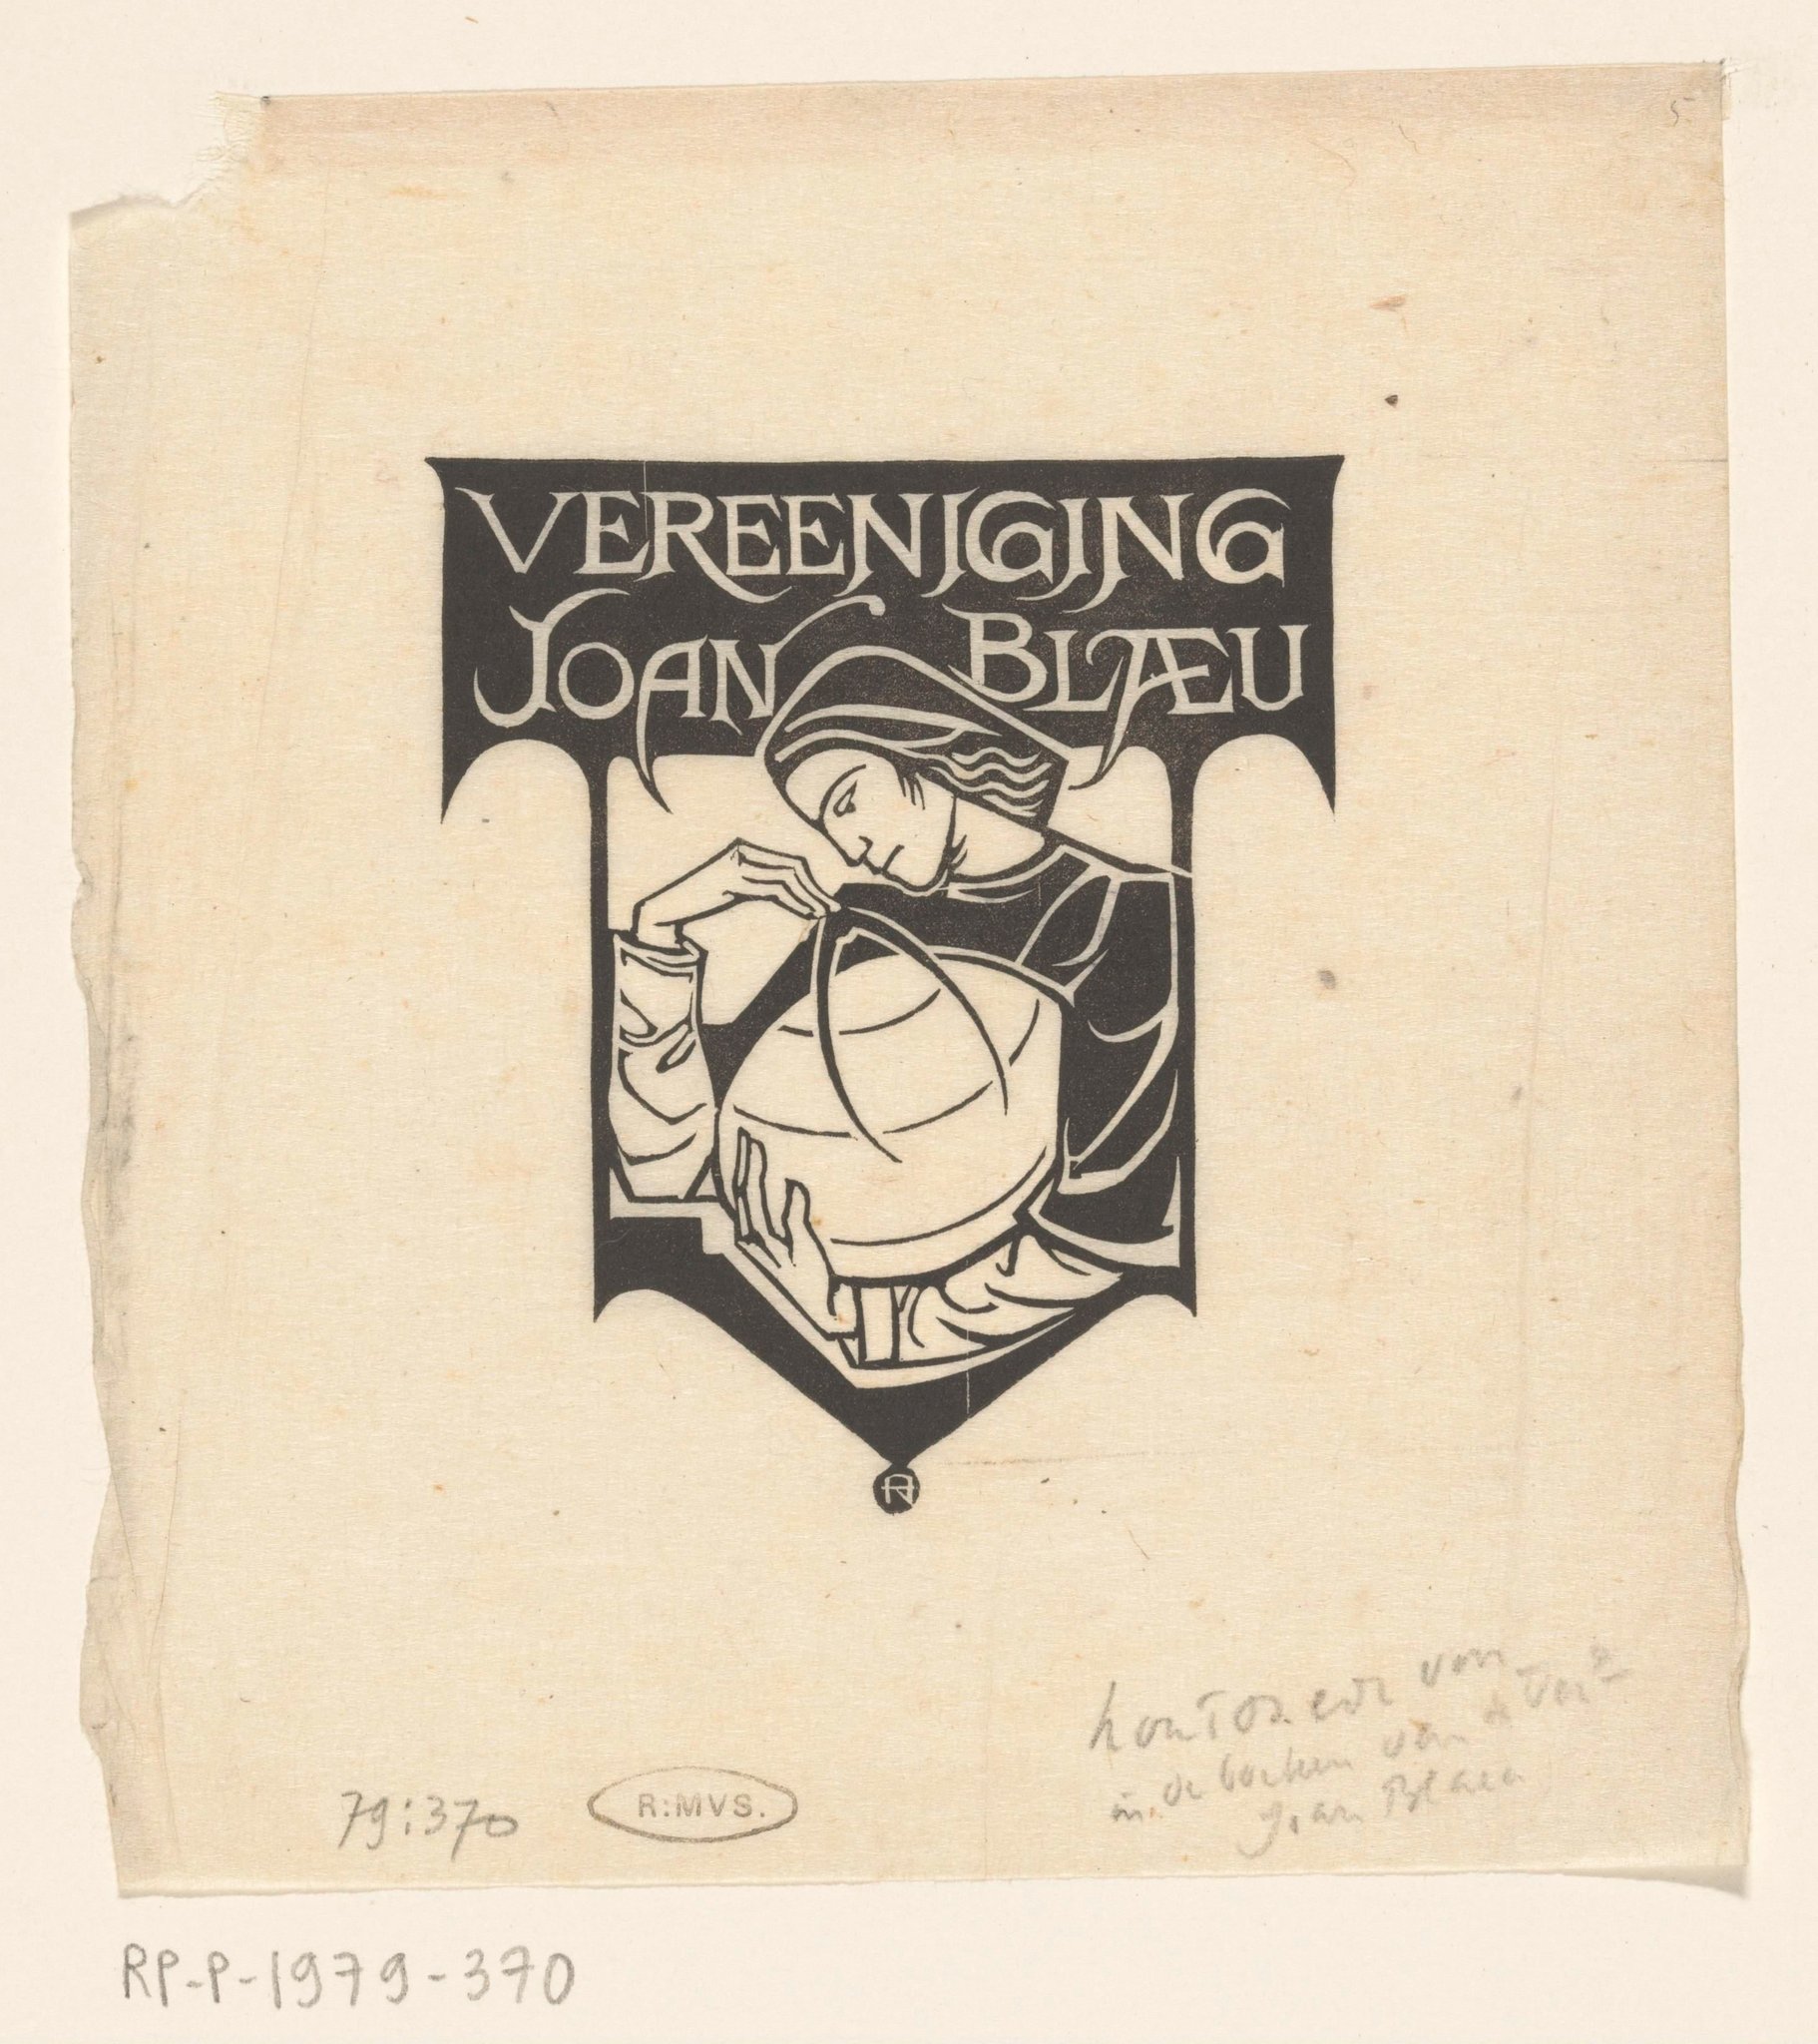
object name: print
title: Ex libris van de Vereeniging Joan Blaeu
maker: richard nicolaüs roland holst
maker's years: 1868-1938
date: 1918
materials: paper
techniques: woodcut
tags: measuring-instruments, globe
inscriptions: collector's mark: Lugt 2228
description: Een figuur die met een passer afmetingen maakt op een globe.